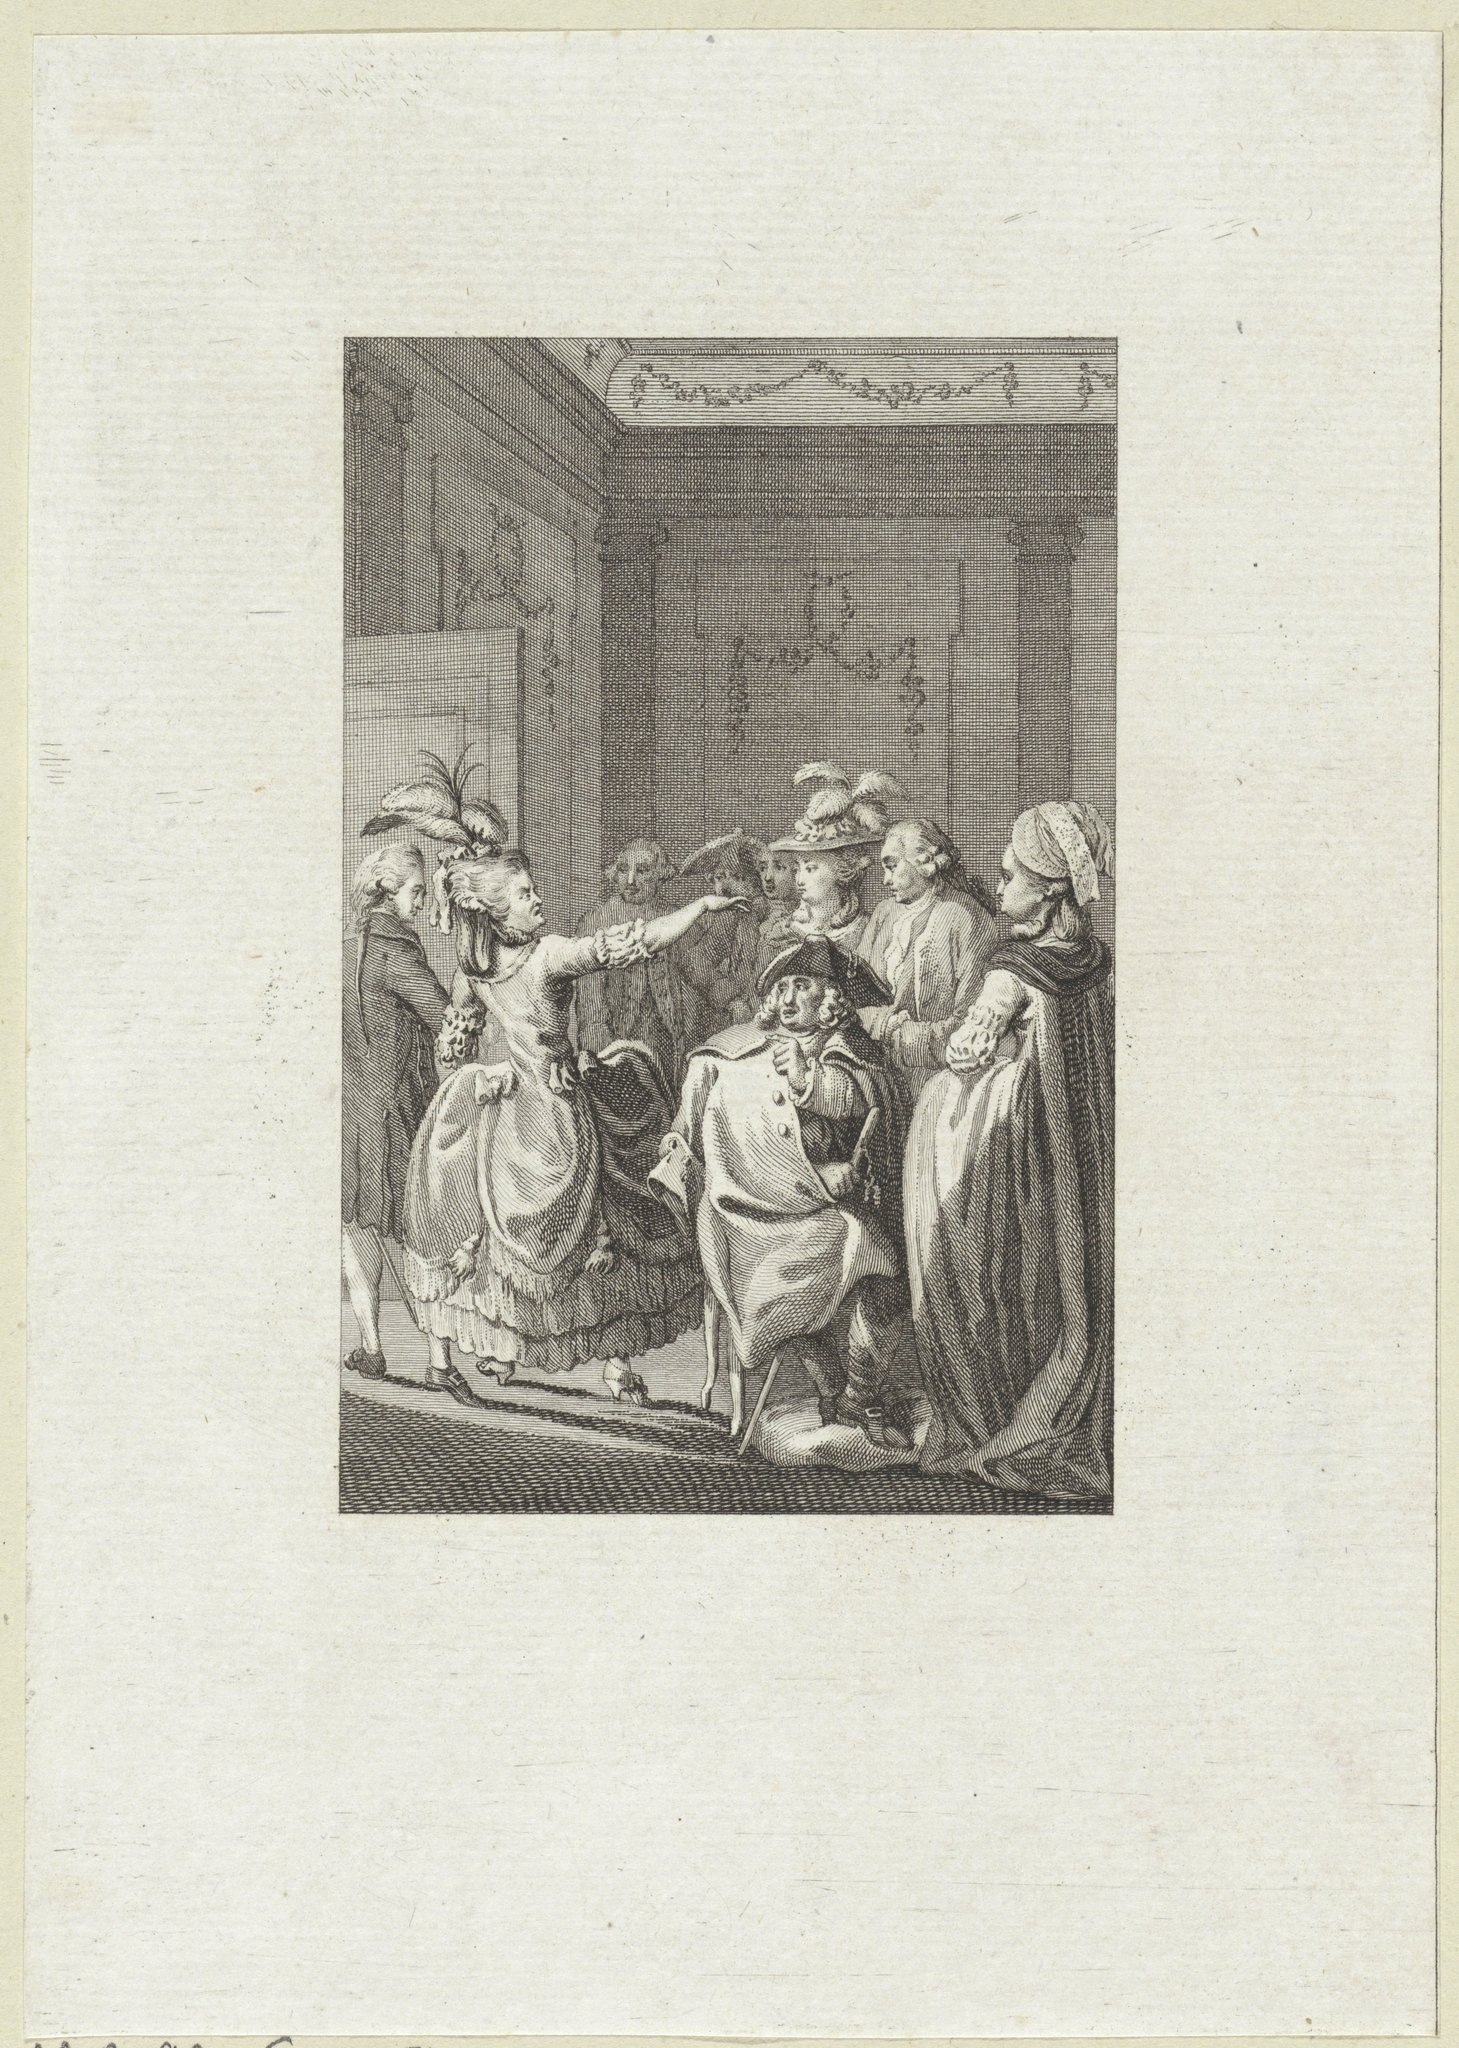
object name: print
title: Paar verlaat woedend een gezelschap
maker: reinier vinkeles (i)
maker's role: draughtsman, print maker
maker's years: 1741-1816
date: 1784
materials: paper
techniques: engraving, etching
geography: amsterdam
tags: vehemence, violence, fierceness; 'sforza con inganno', 'violenza' (ripa), pillow, aggressive relationships, enmity, animosity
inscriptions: collector's mark: Lugt 240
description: Proefdruk van illustratie in: De Ouderwetsche Trant. Amsterdam: Pieter Meĳer, 1784.